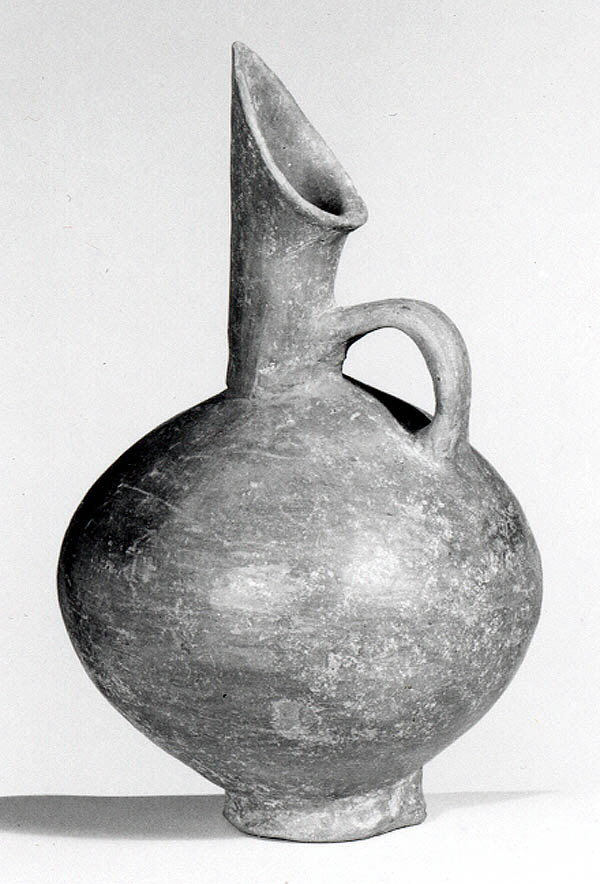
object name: jug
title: Spouted jug with a mottled surface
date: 2700-2400 BCE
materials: ceramic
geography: northwestern anatolia